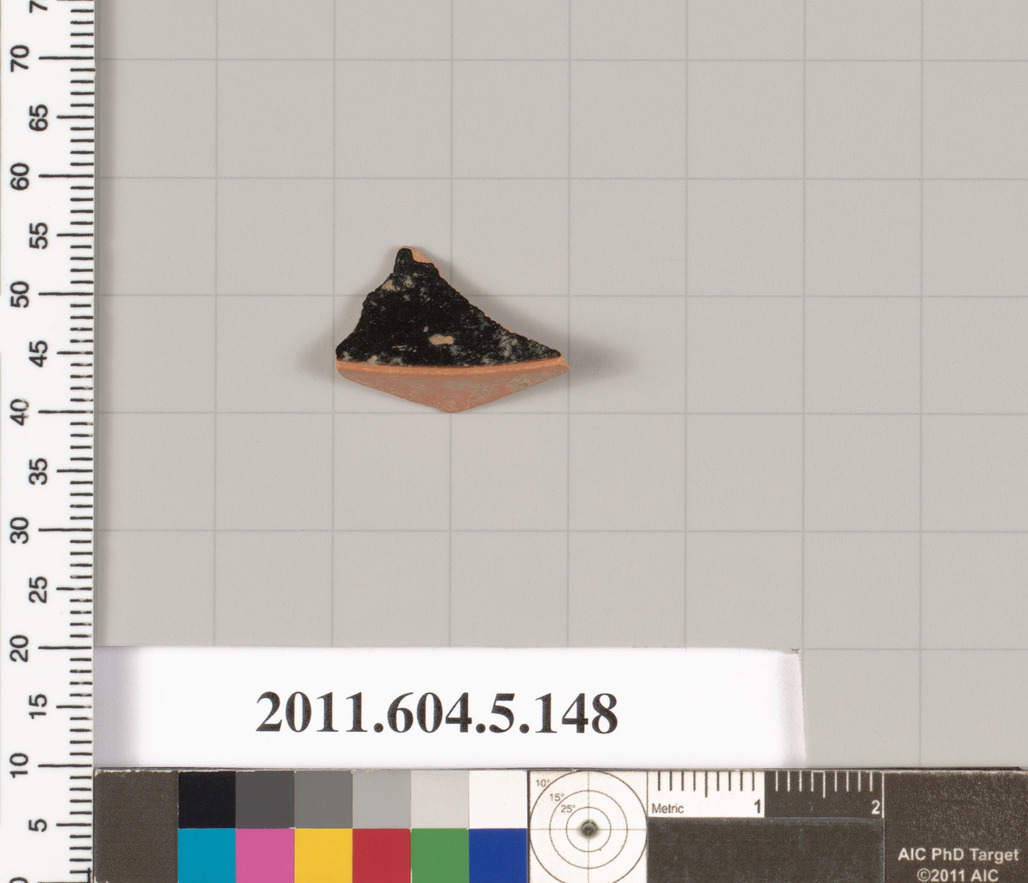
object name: kylix fragment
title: Terracotta fragment of a kylix (drinking cup)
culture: greek, attic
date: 600-401 BCE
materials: terracotta